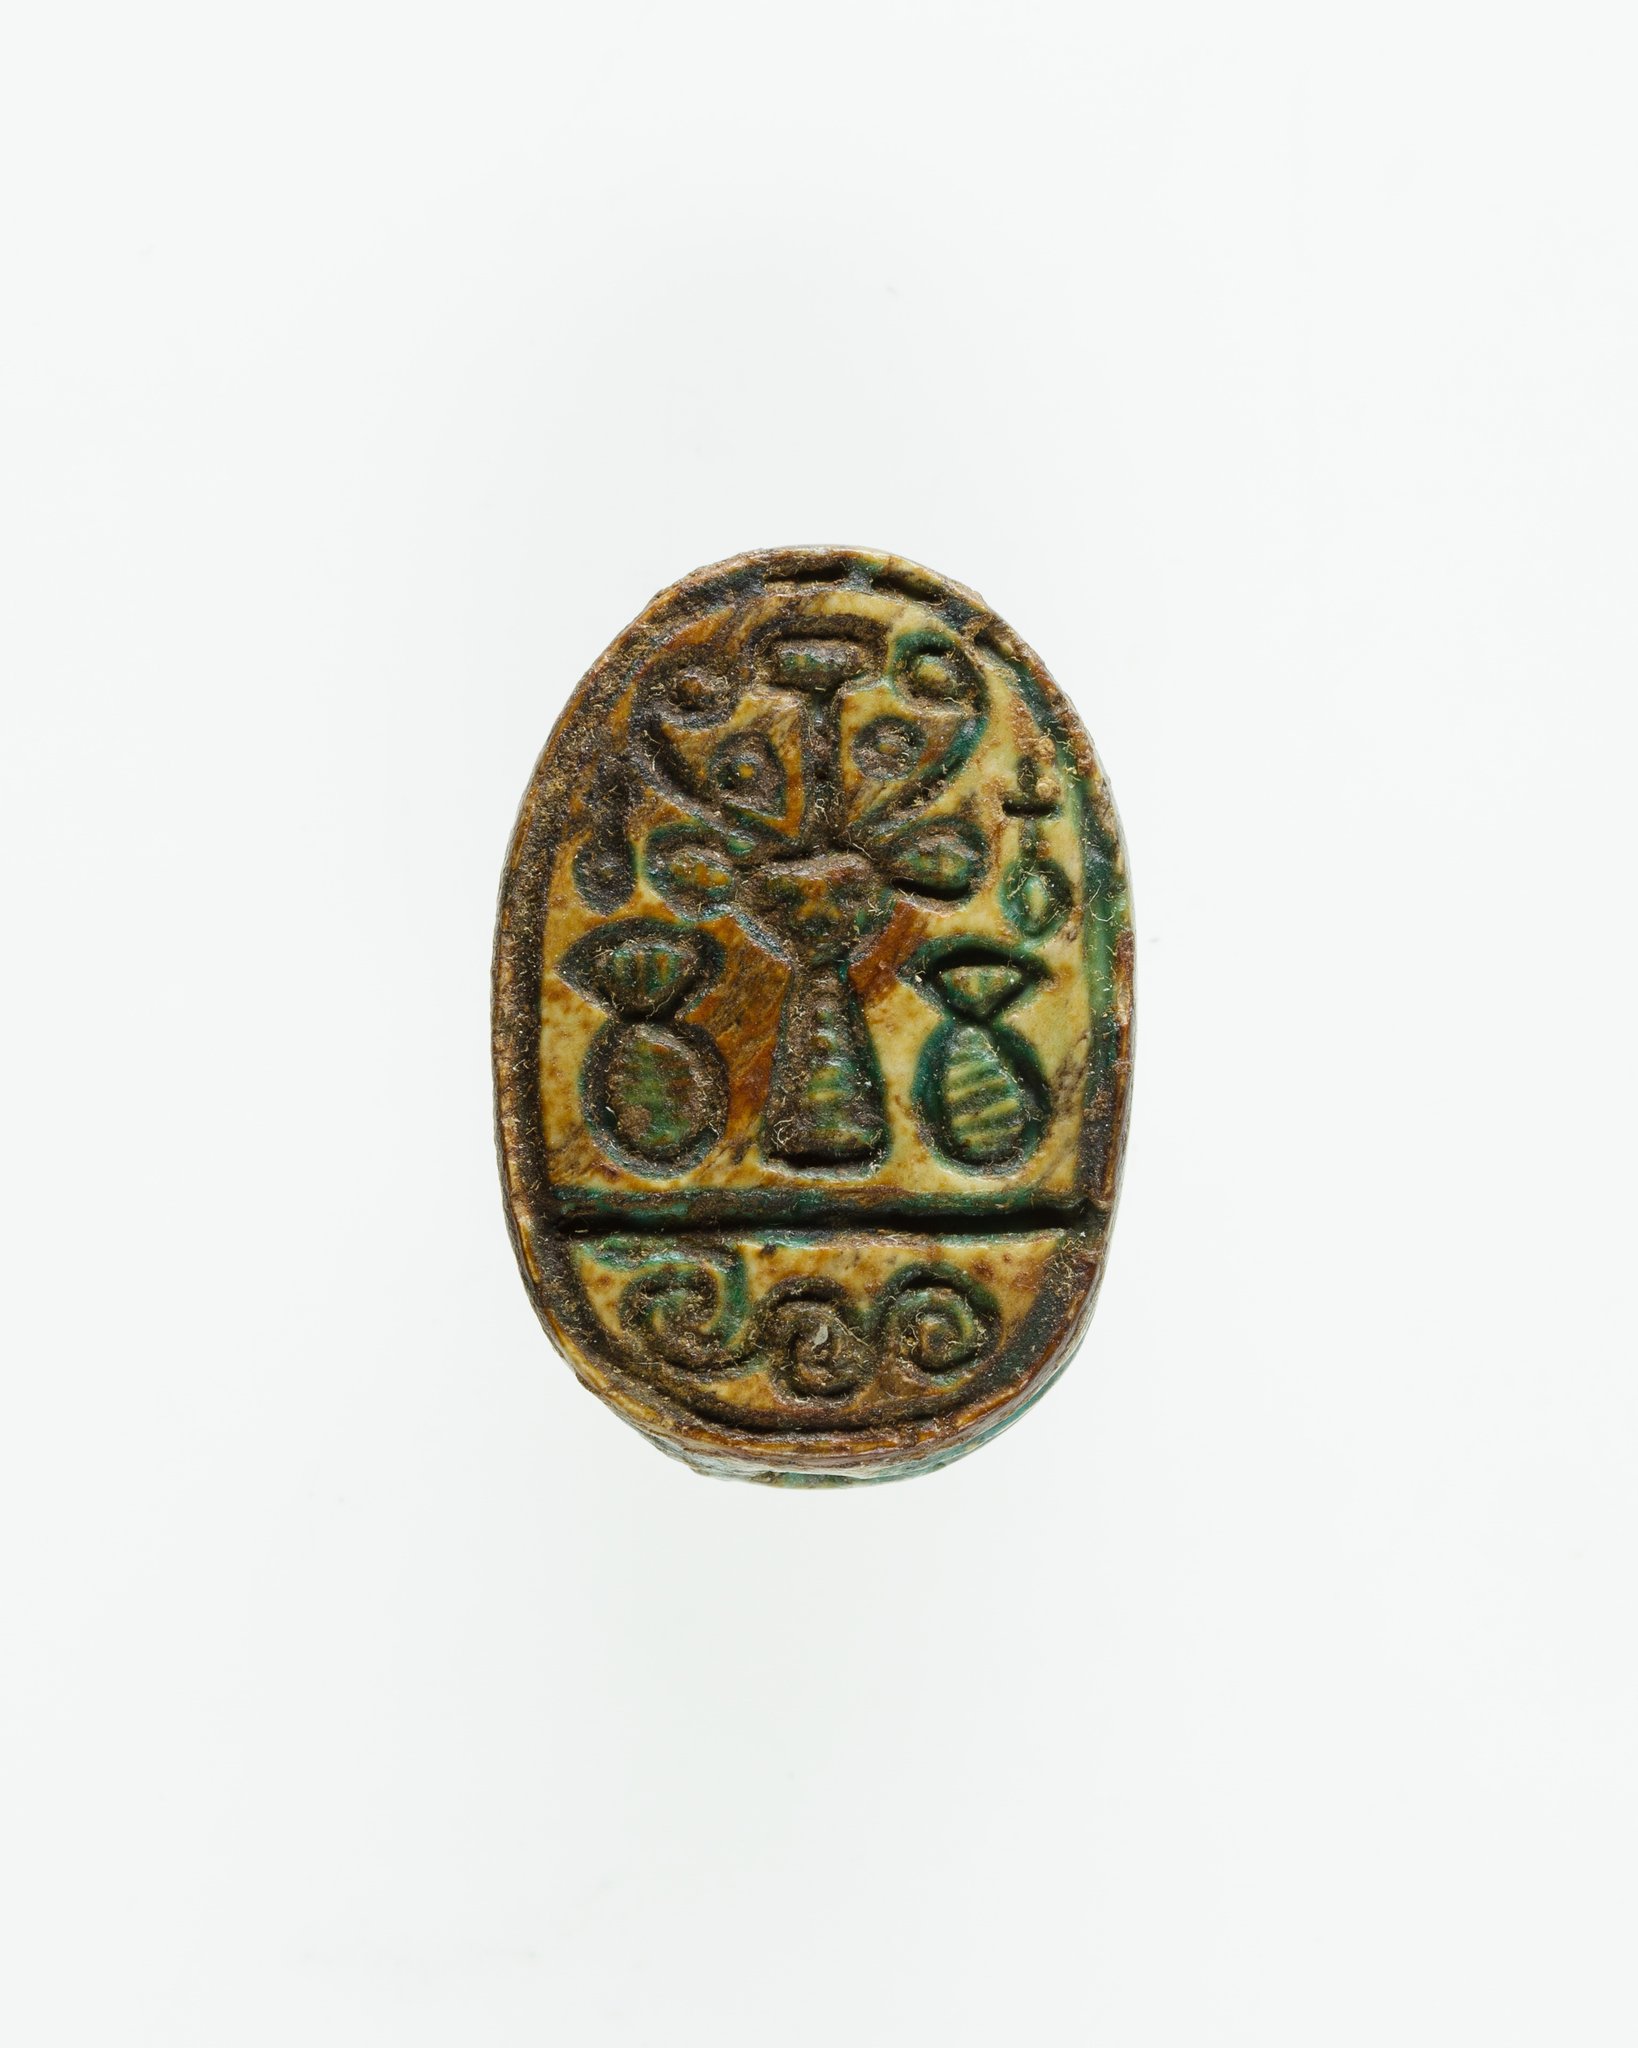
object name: scarab, hathor emblem, sistrum, nfr, wadj papyrus, spiral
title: Scarab with Hieroglyphs and Hathor Sistrum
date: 1760-1670 BCE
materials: stone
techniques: glazing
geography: egypt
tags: hieroglyphs,scarabs